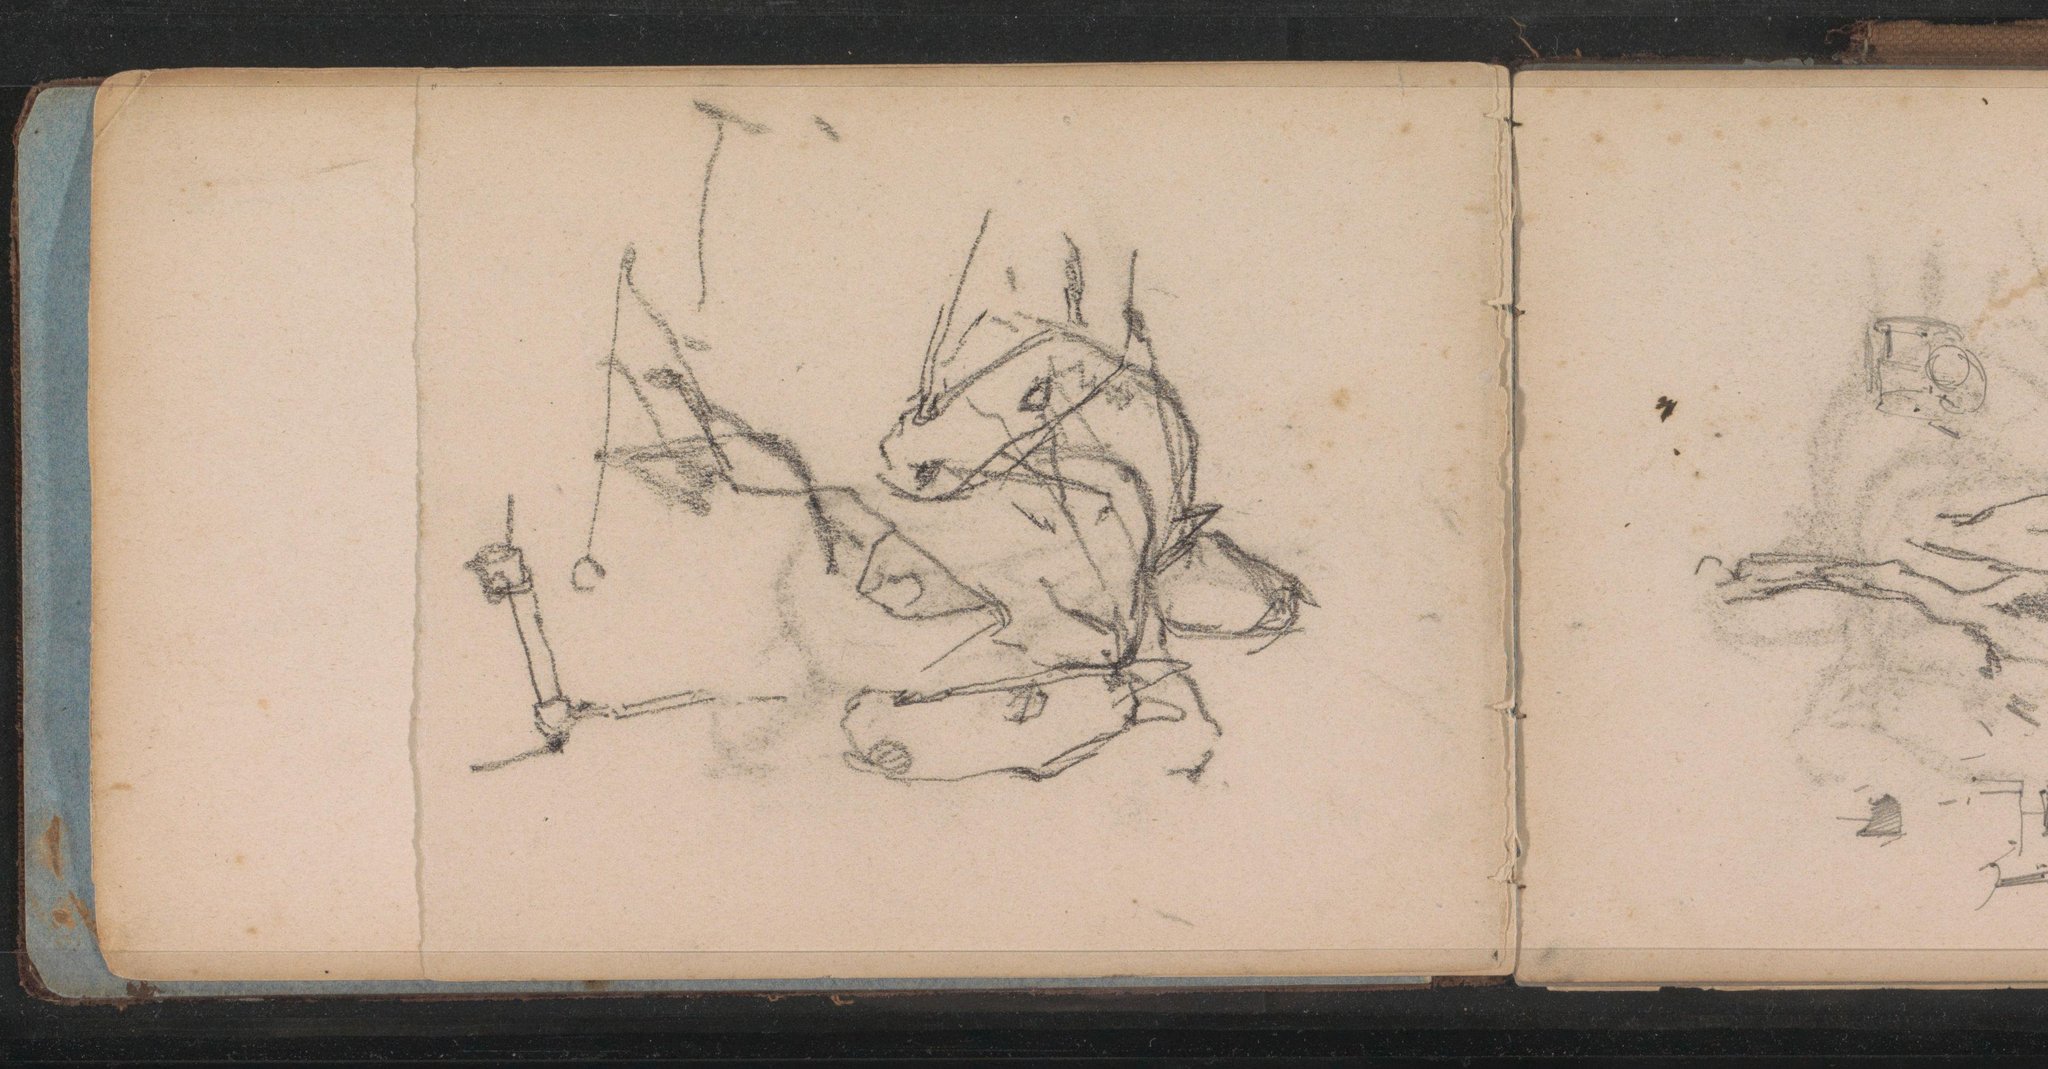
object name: sketchbook leaf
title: Aangespannen paarden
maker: george hendrik breitner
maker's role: draughtsman, painter, print maker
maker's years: 1857-1923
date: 1880-1882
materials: chalk, paper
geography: scheveningen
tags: horse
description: Pagina 11 uit een schetsboek met 37 bladen.